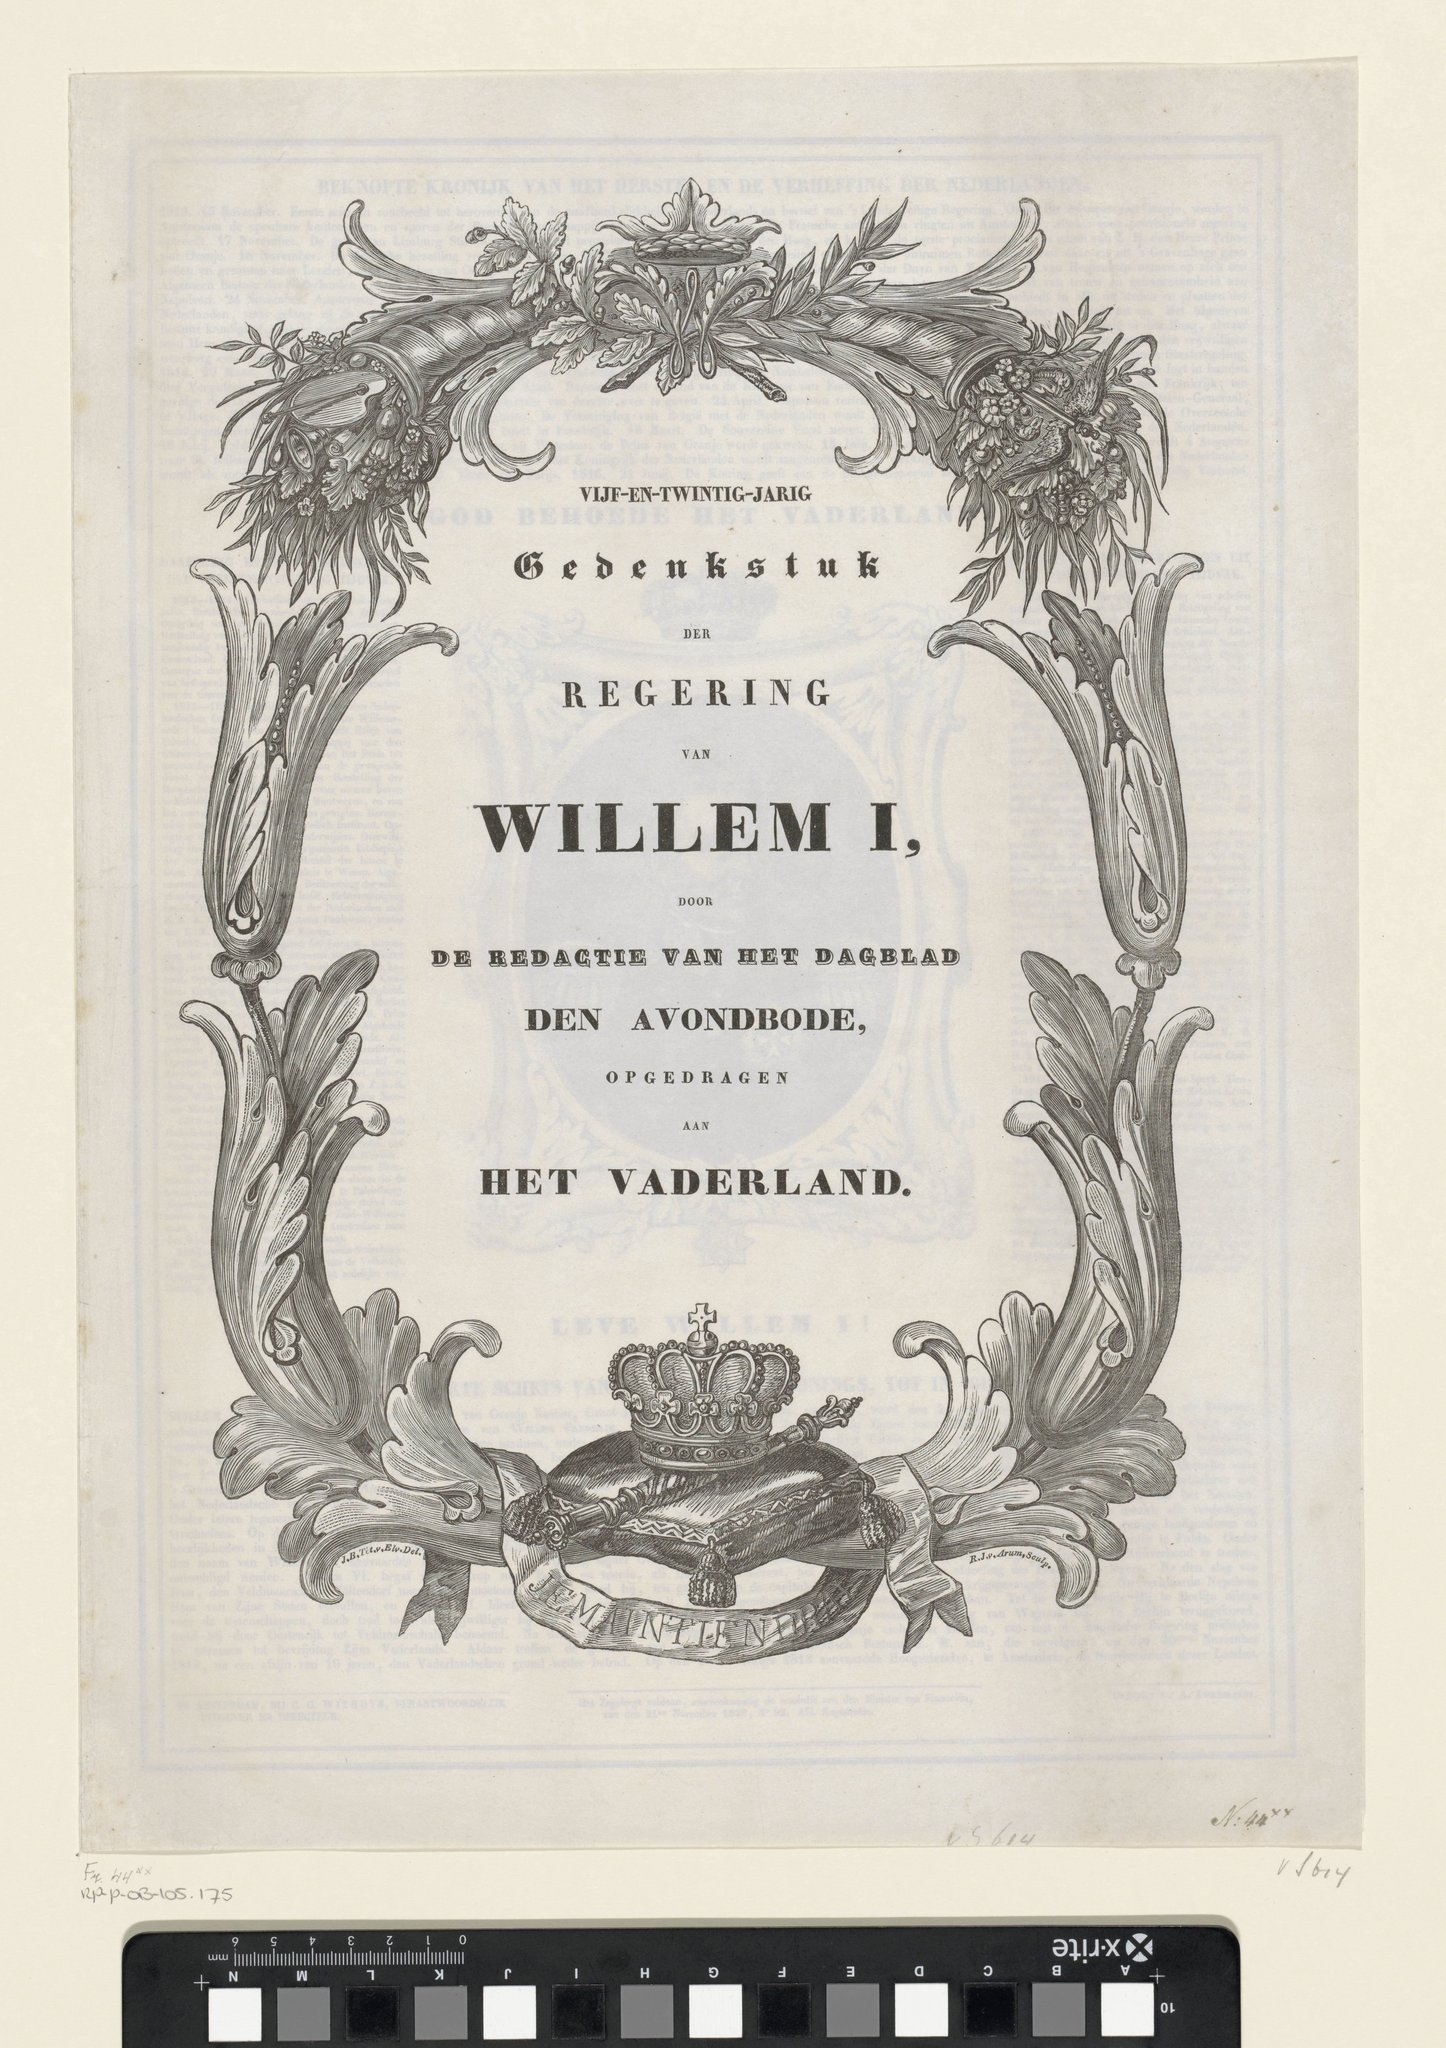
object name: newspaper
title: Vijf-en-twintig-jarig Gedenkstuk der regering van Willem I, door de redactie van het dagblad Den Avondbode, opgedragen aan het vaderland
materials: paper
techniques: letterpress printing, lithograph, engraving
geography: netherlands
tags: berlin, william i of the netherlands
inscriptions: date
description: Gedenkstuk ter ere van het 25-jarig regeringsjubileum van Willem I Frederik, 1838. Op de voorpagina Nederlandse tekst in boekdruk in een geornamenteerde omlijsting met allegorische objecten. Verder een portret van Willem I Frederik in een geornamenteerde omlijsting. Daar omheen kolommen en kaders met Nederlandse tekst in boekdruk.